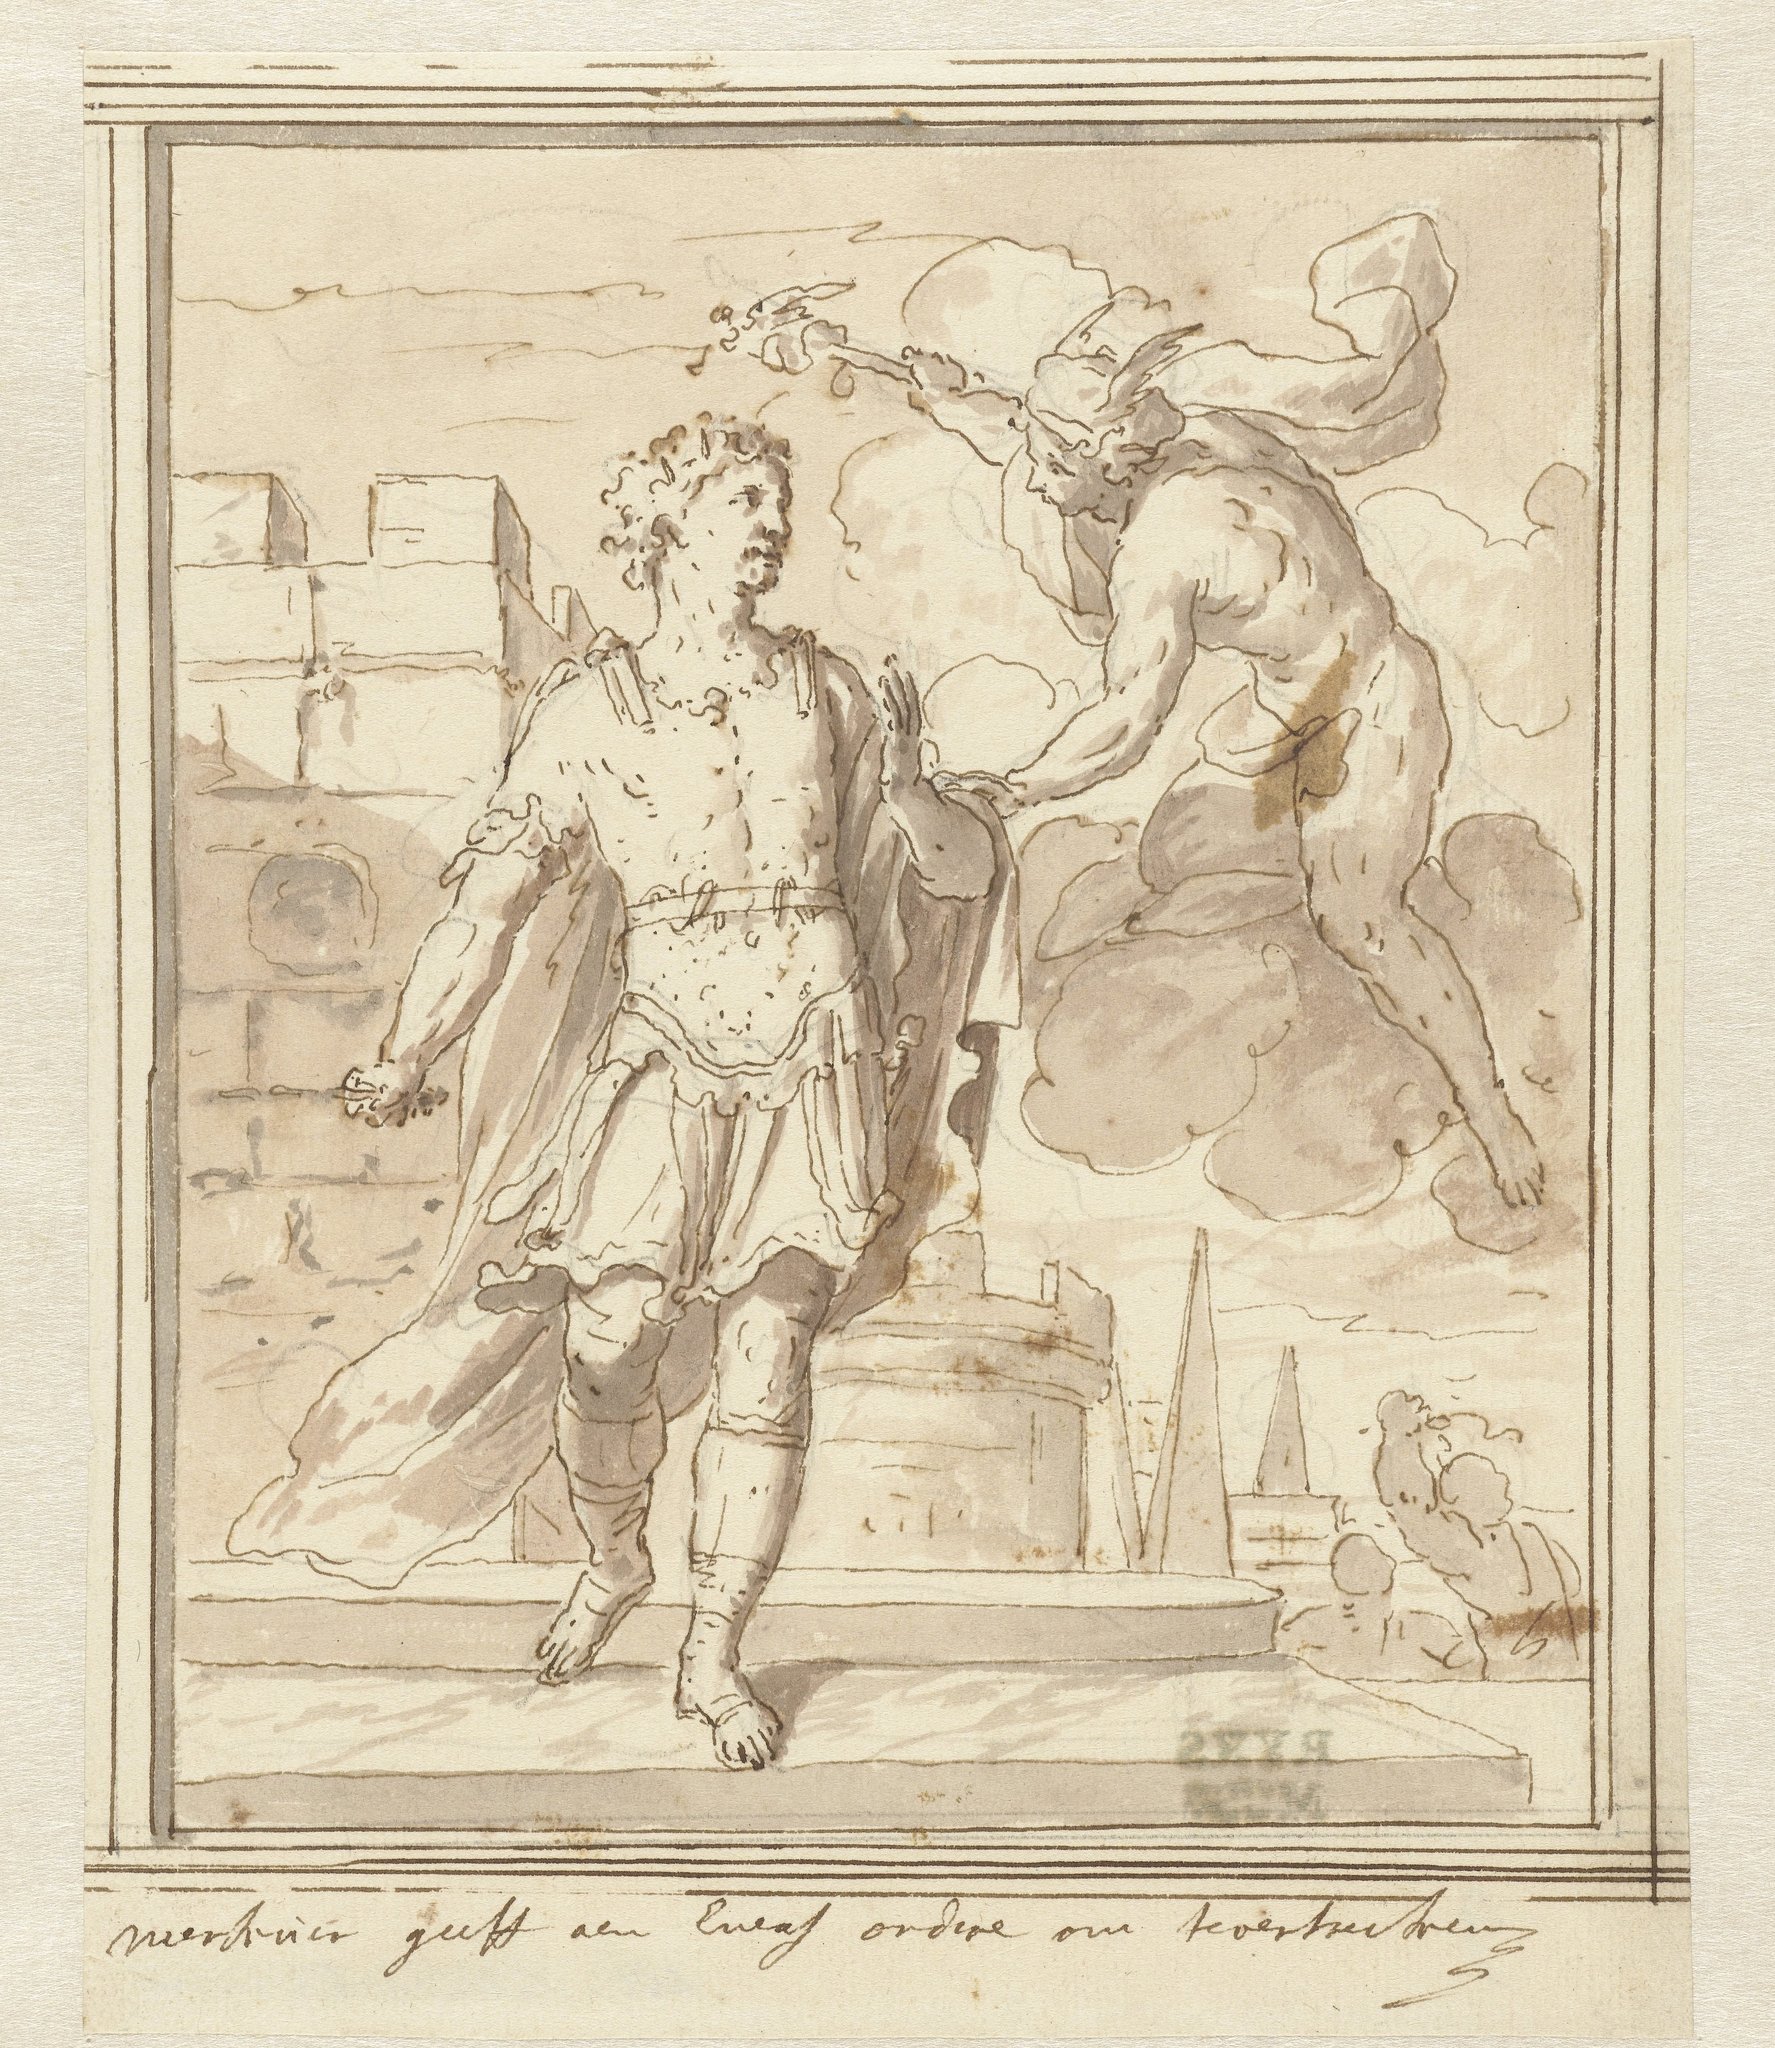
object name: design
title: Mercurius beveelt Aeneas te vertrekken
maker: mattheus terwesten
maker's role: draughtsman, painter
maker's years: 1670-1757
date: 1700-1704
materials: ink, paper, pencil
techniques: brush, pen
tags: mercury summons aeneas, engaged in building activities, to leave carthage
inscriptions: : ‘Merkuer geeft aen Eneas ordere om te vertrecken’